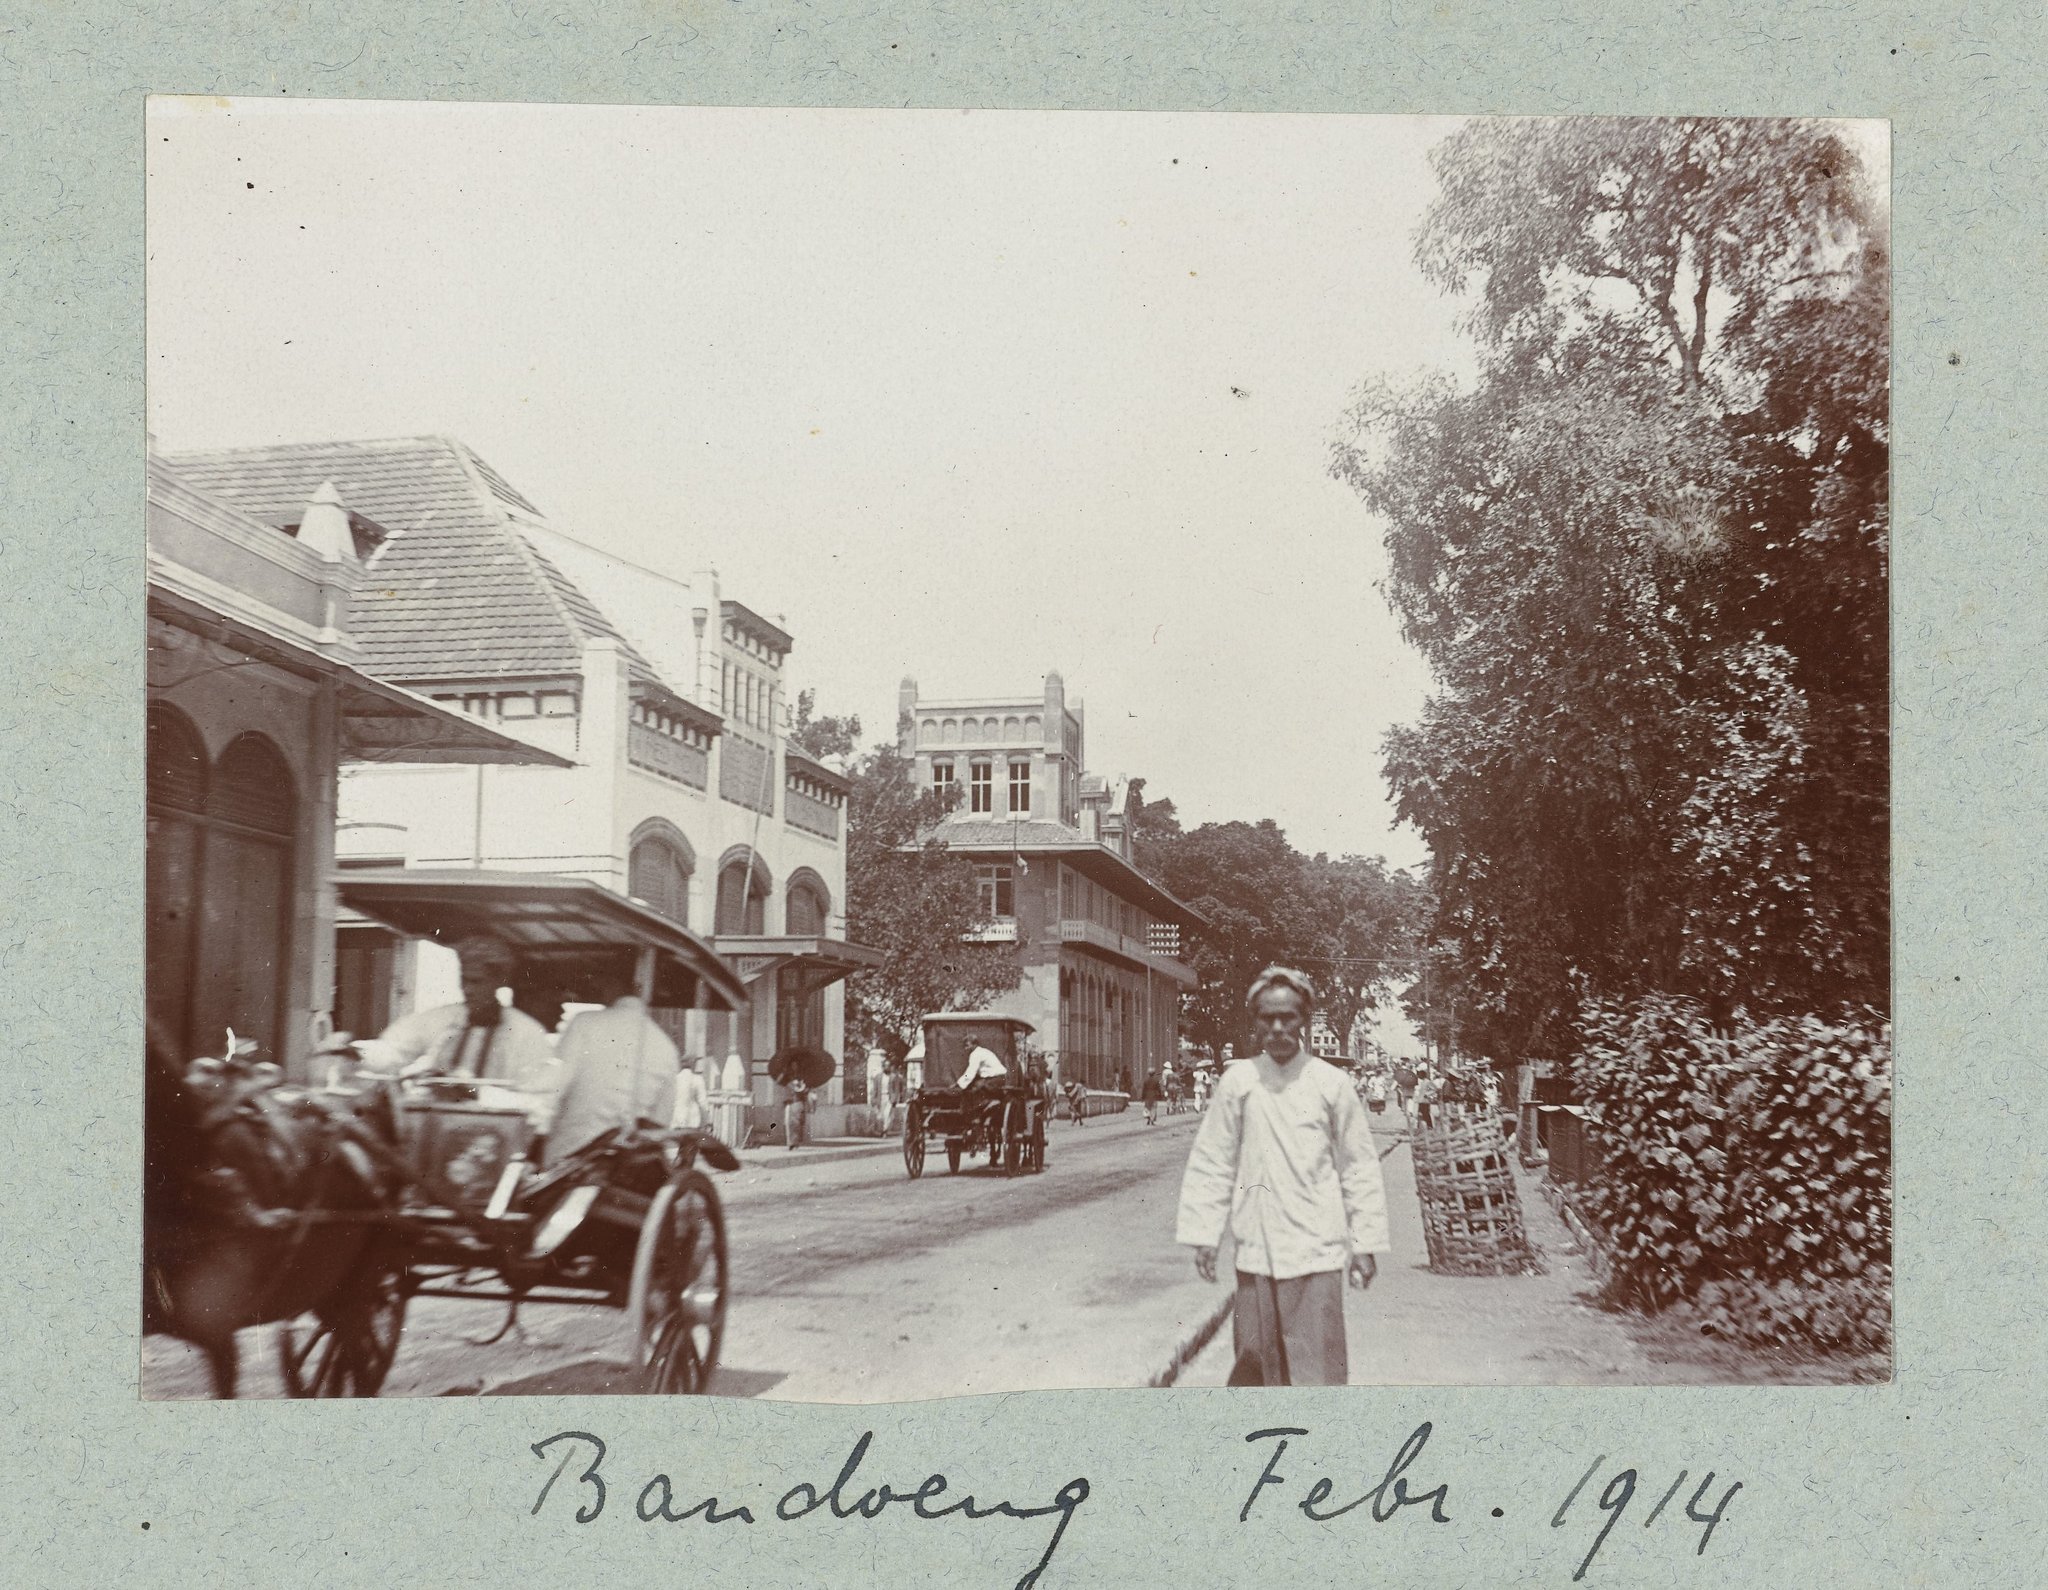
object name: photograph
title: Photographieën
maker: frits freerks fontein fz.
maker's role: fotograaf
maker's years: 1882-1928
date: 1912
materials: cardboard, paper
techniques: gelatin silver print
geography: madura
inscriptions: caption: ‘Bandoeng Febr. 1914’